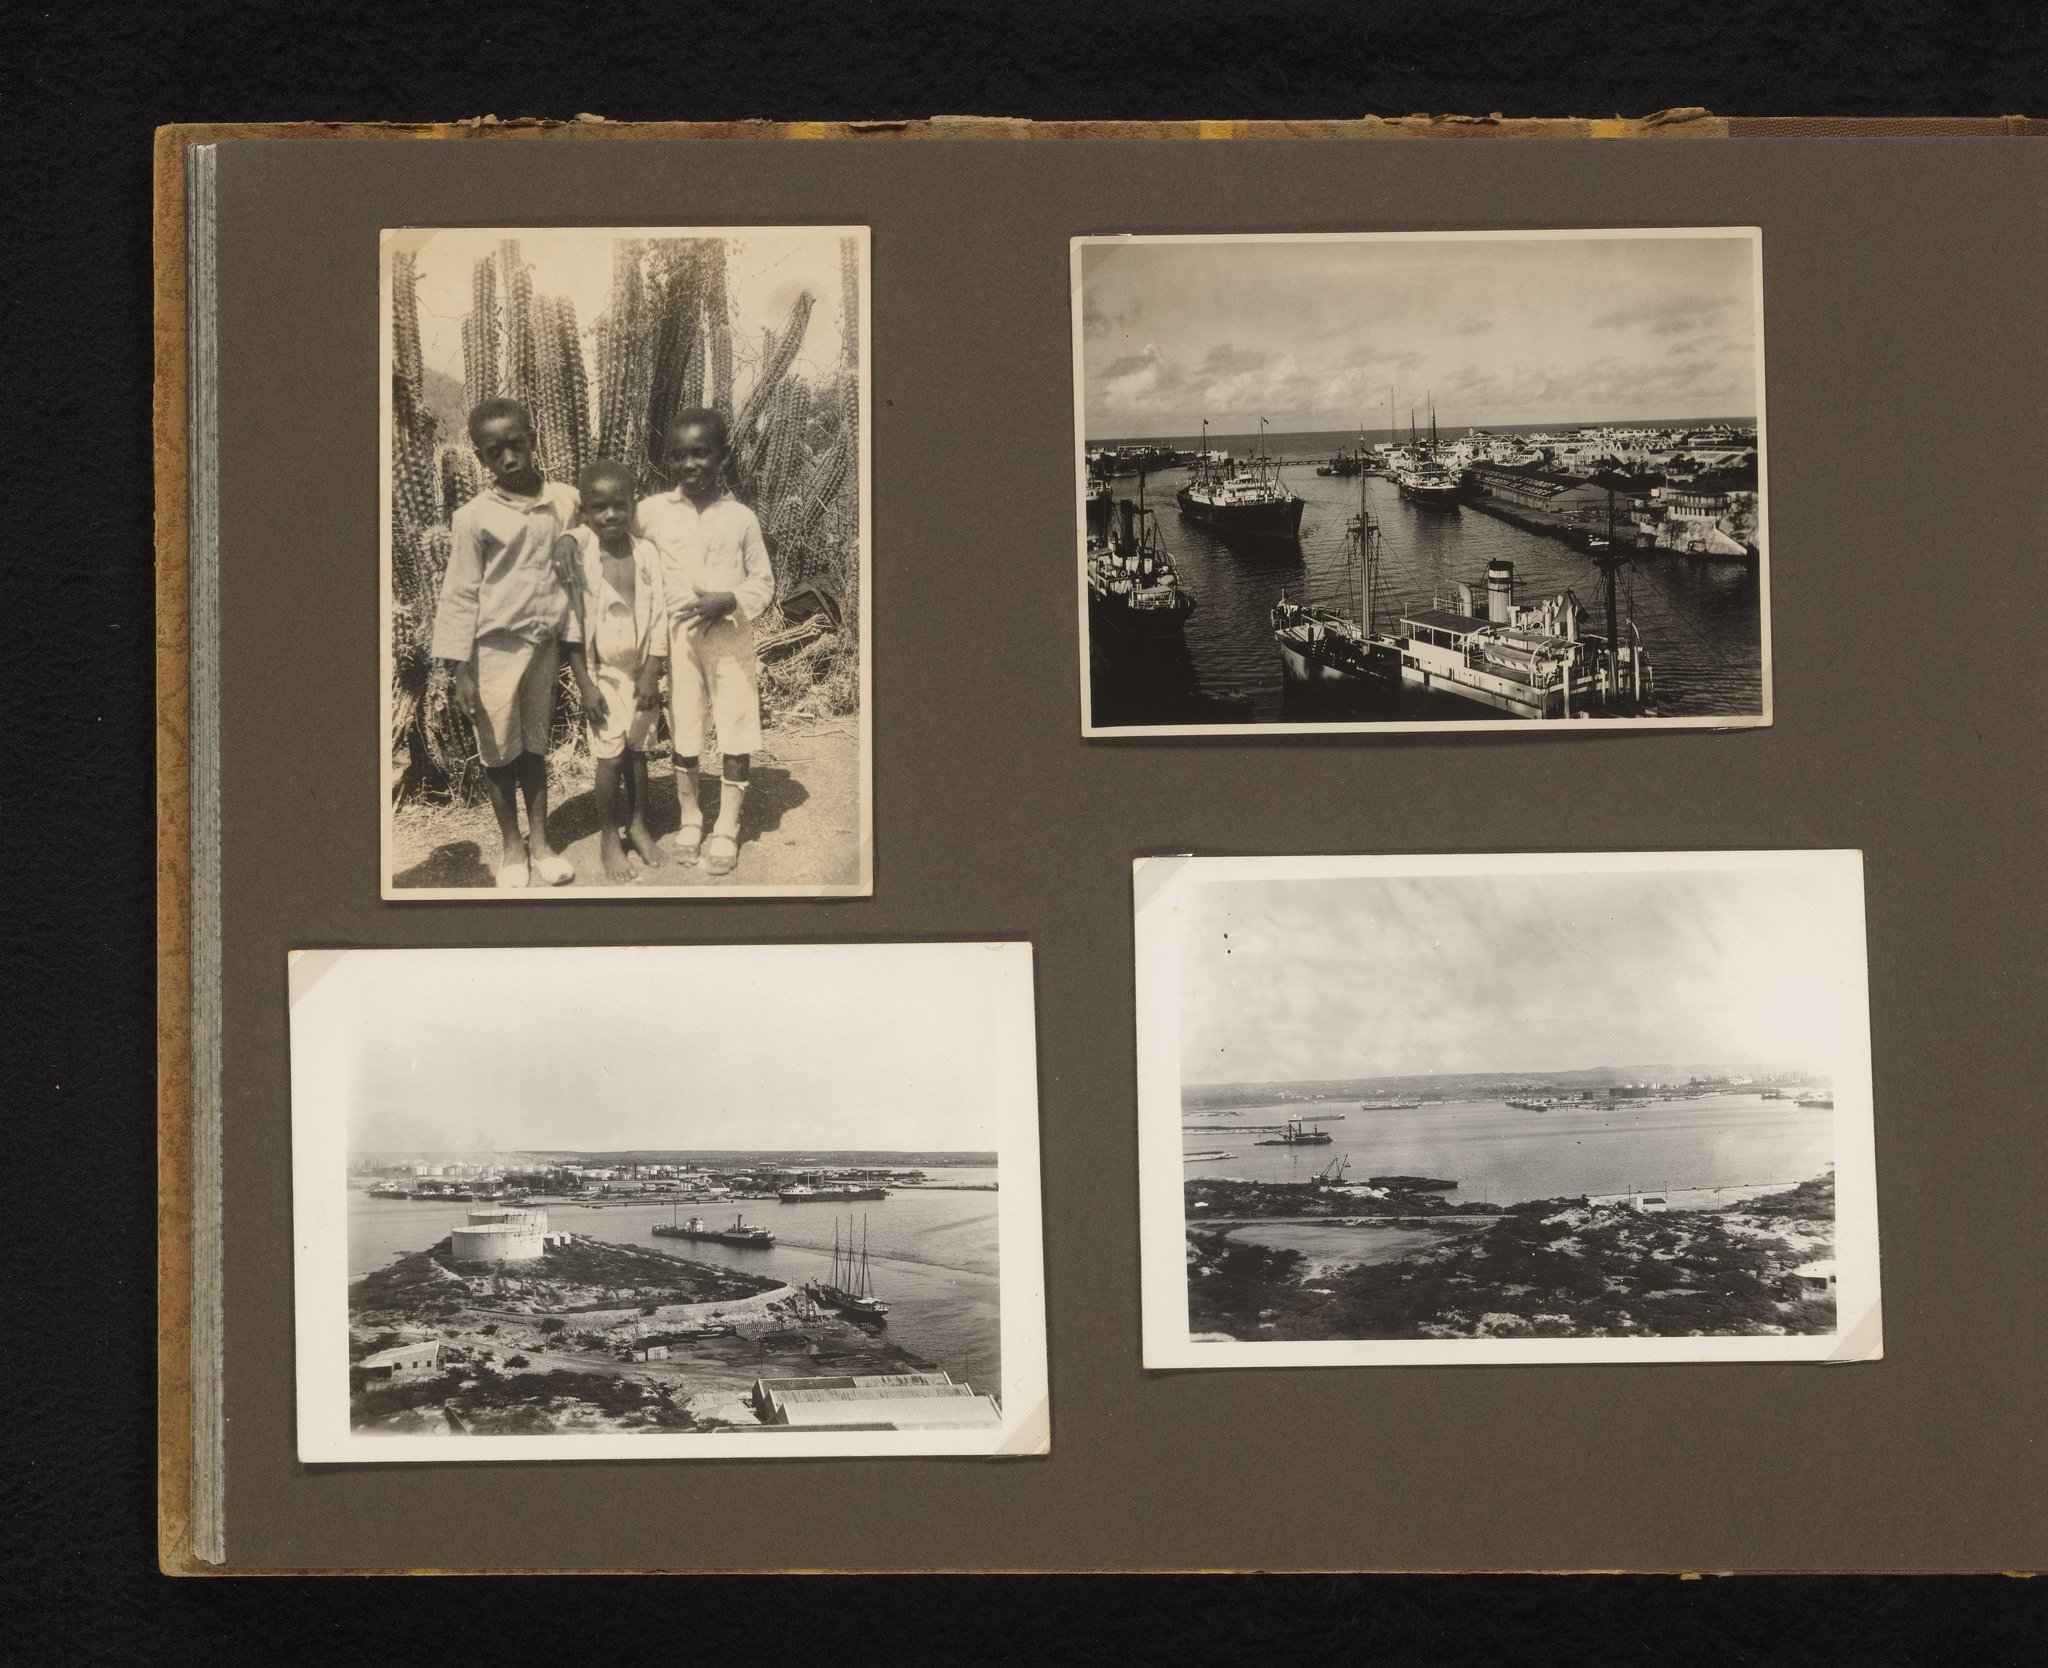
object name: photograph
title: Haven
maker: Anonymous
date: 1931-1934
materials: paper, photographic support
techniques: gelatin silver print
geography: curacao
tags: harbour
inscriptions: name: ‘Fotohandel / Sunny Isle / Curacao Dwi.’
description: Albumblad met vier gekochte foto's met gezichten van de haven en van drie lokale jongens. Onderdeel van het fotoalbum van Polidorus Ego over zijn verblijf op Curaçao 1931-1934.